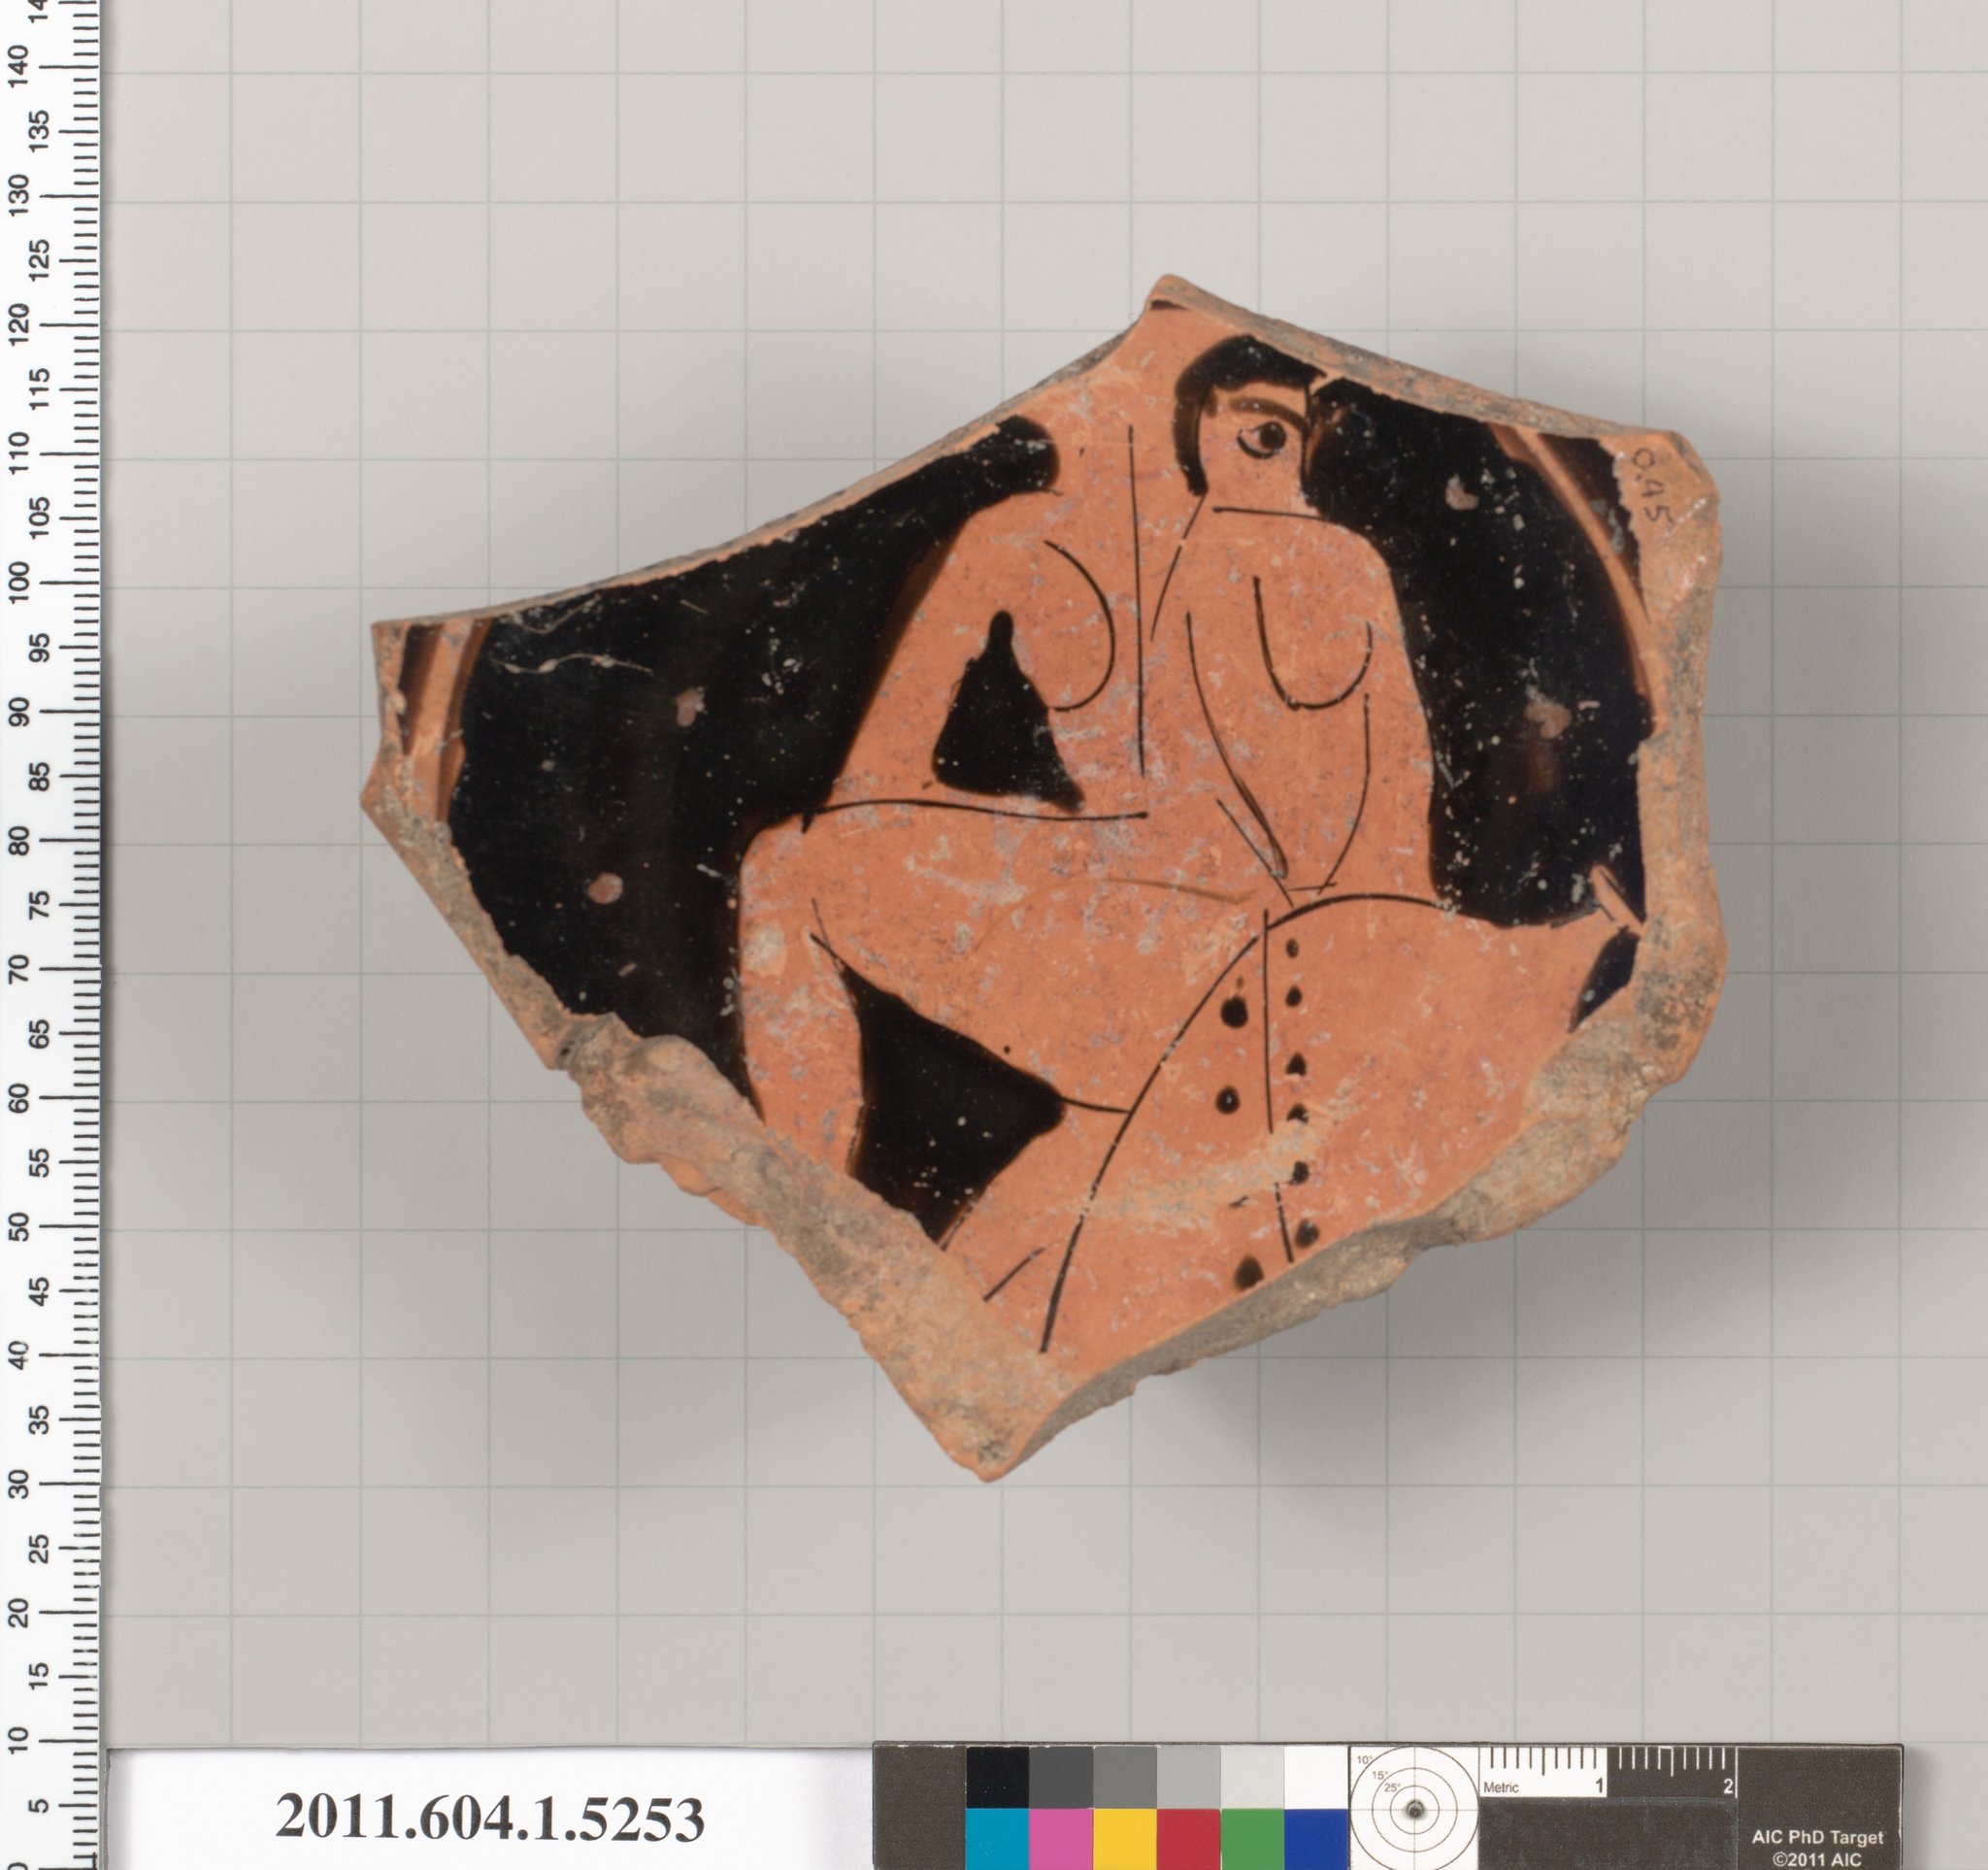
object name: kylix fragment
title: Terracotta fragment of a kylix (drinking cup)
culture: greek, attic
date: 534-468 BCE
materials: terracotta